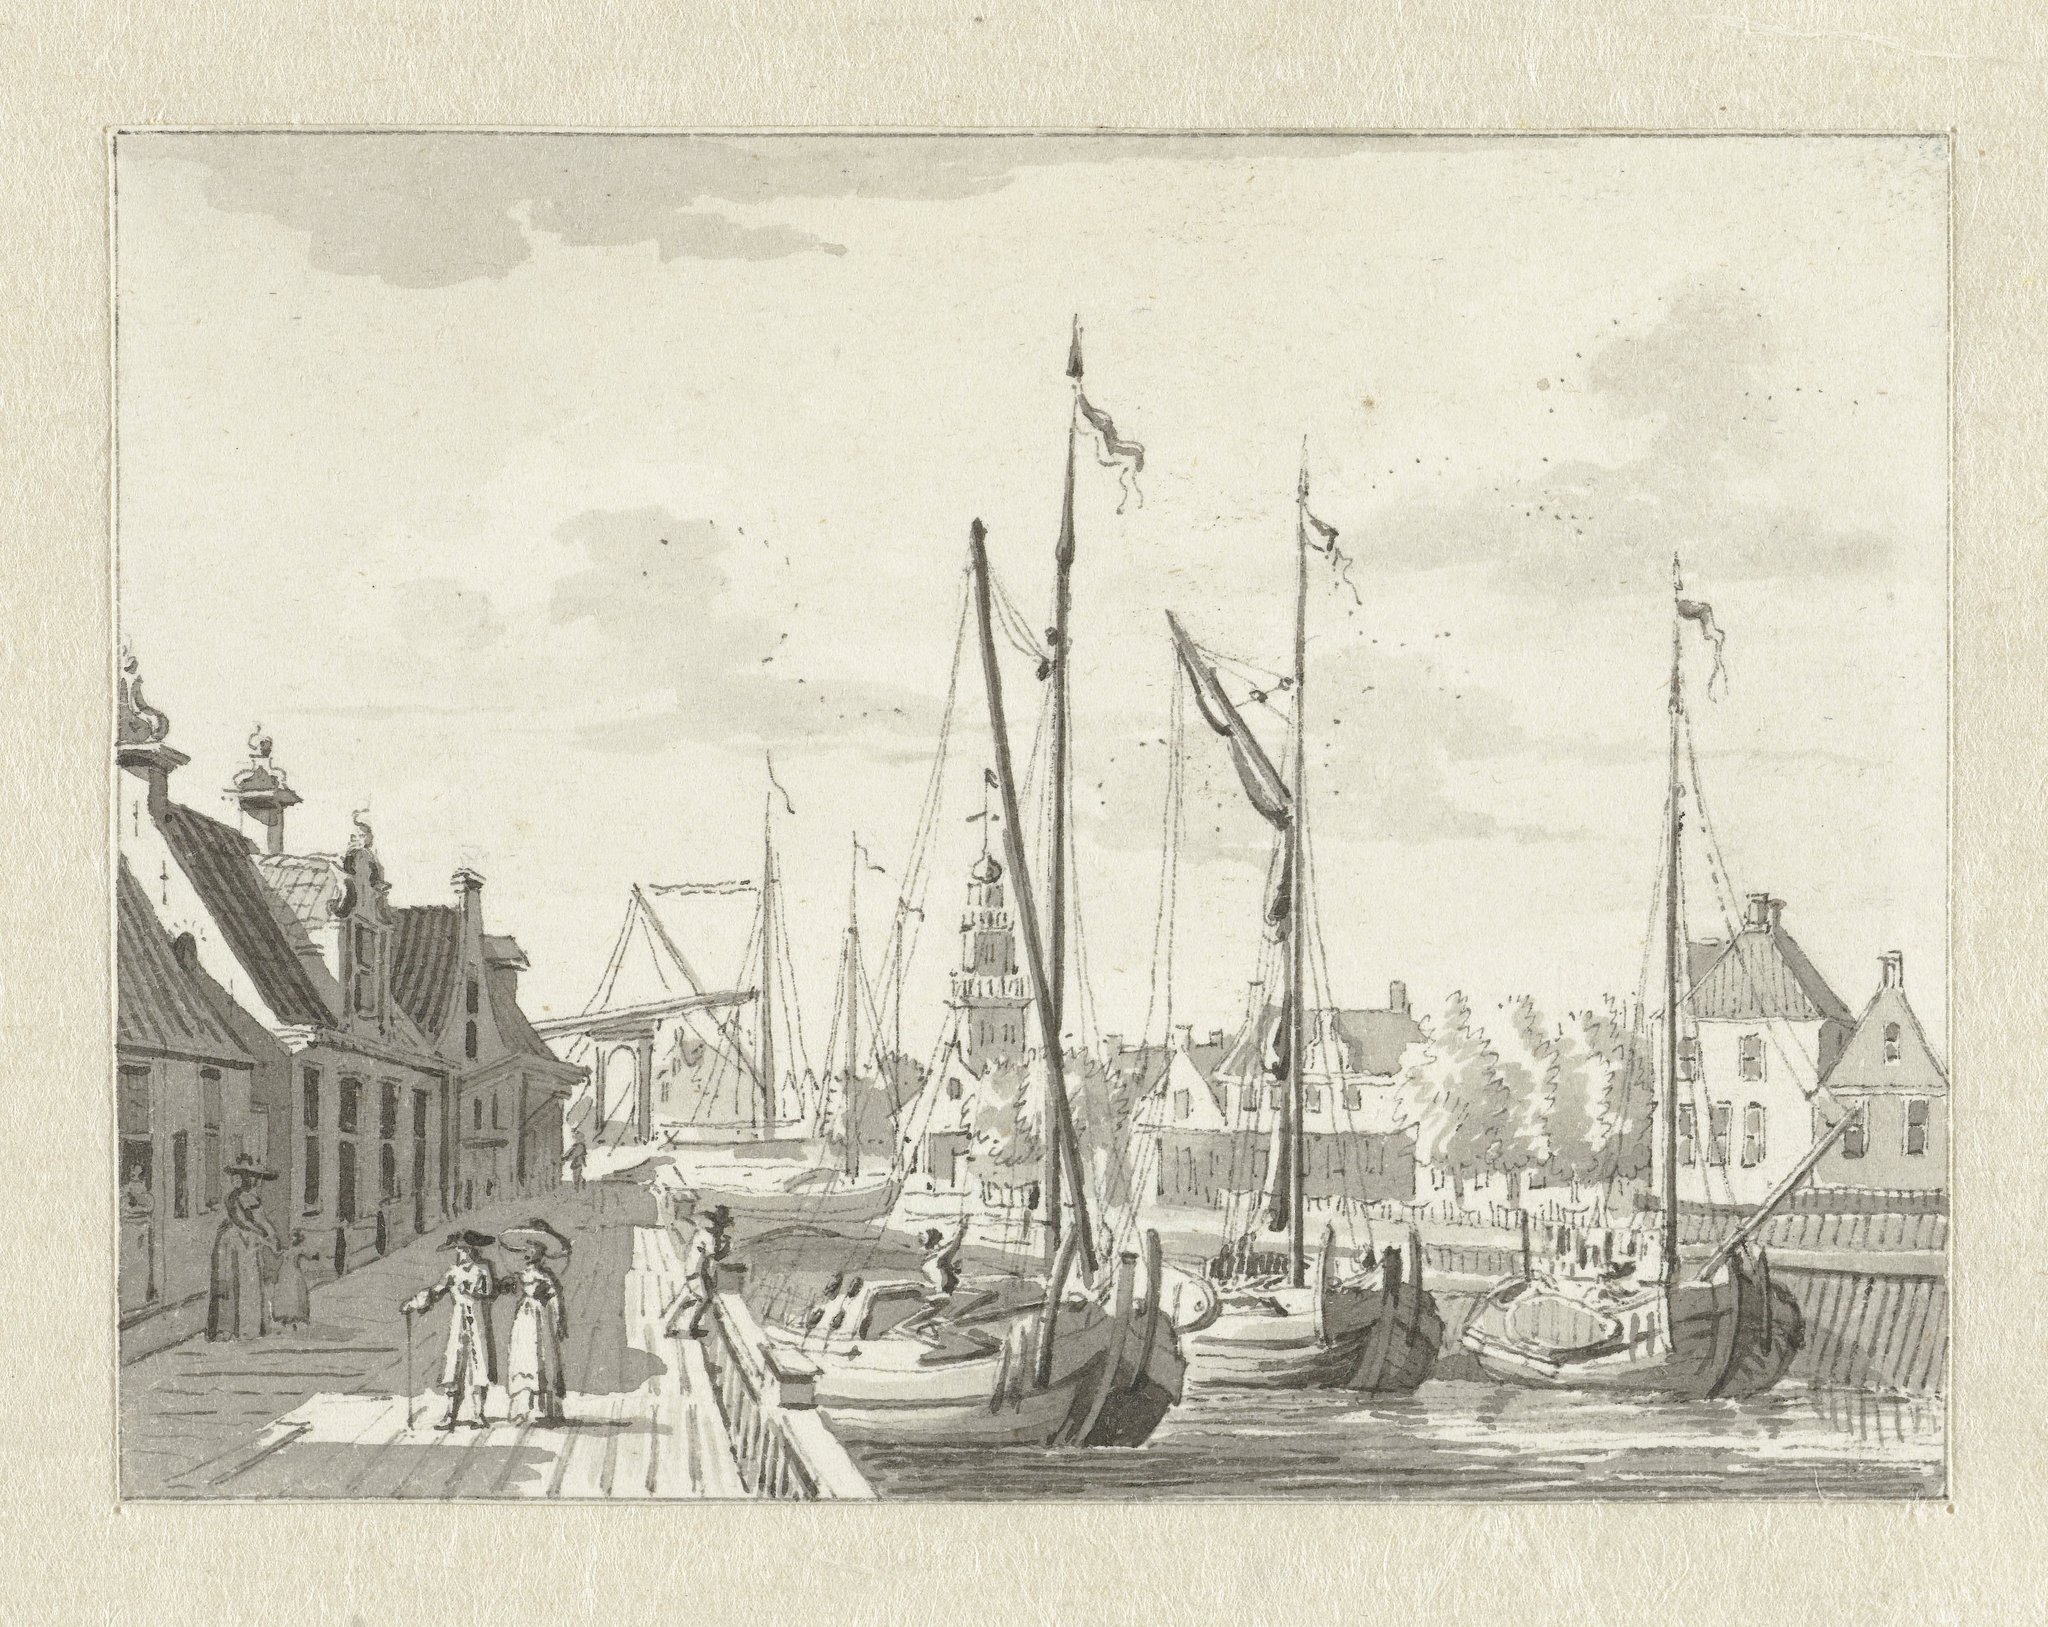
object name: drawing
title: Gezicht te De Lemmer (?)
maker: jan bulthuis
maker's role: draughtsman, print maker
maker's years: 1750-1801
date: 1760-1801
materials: ink, paper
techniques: brush, pen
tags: city-view, and landscape with man-made constructions, sailing-ship, sailing-boat